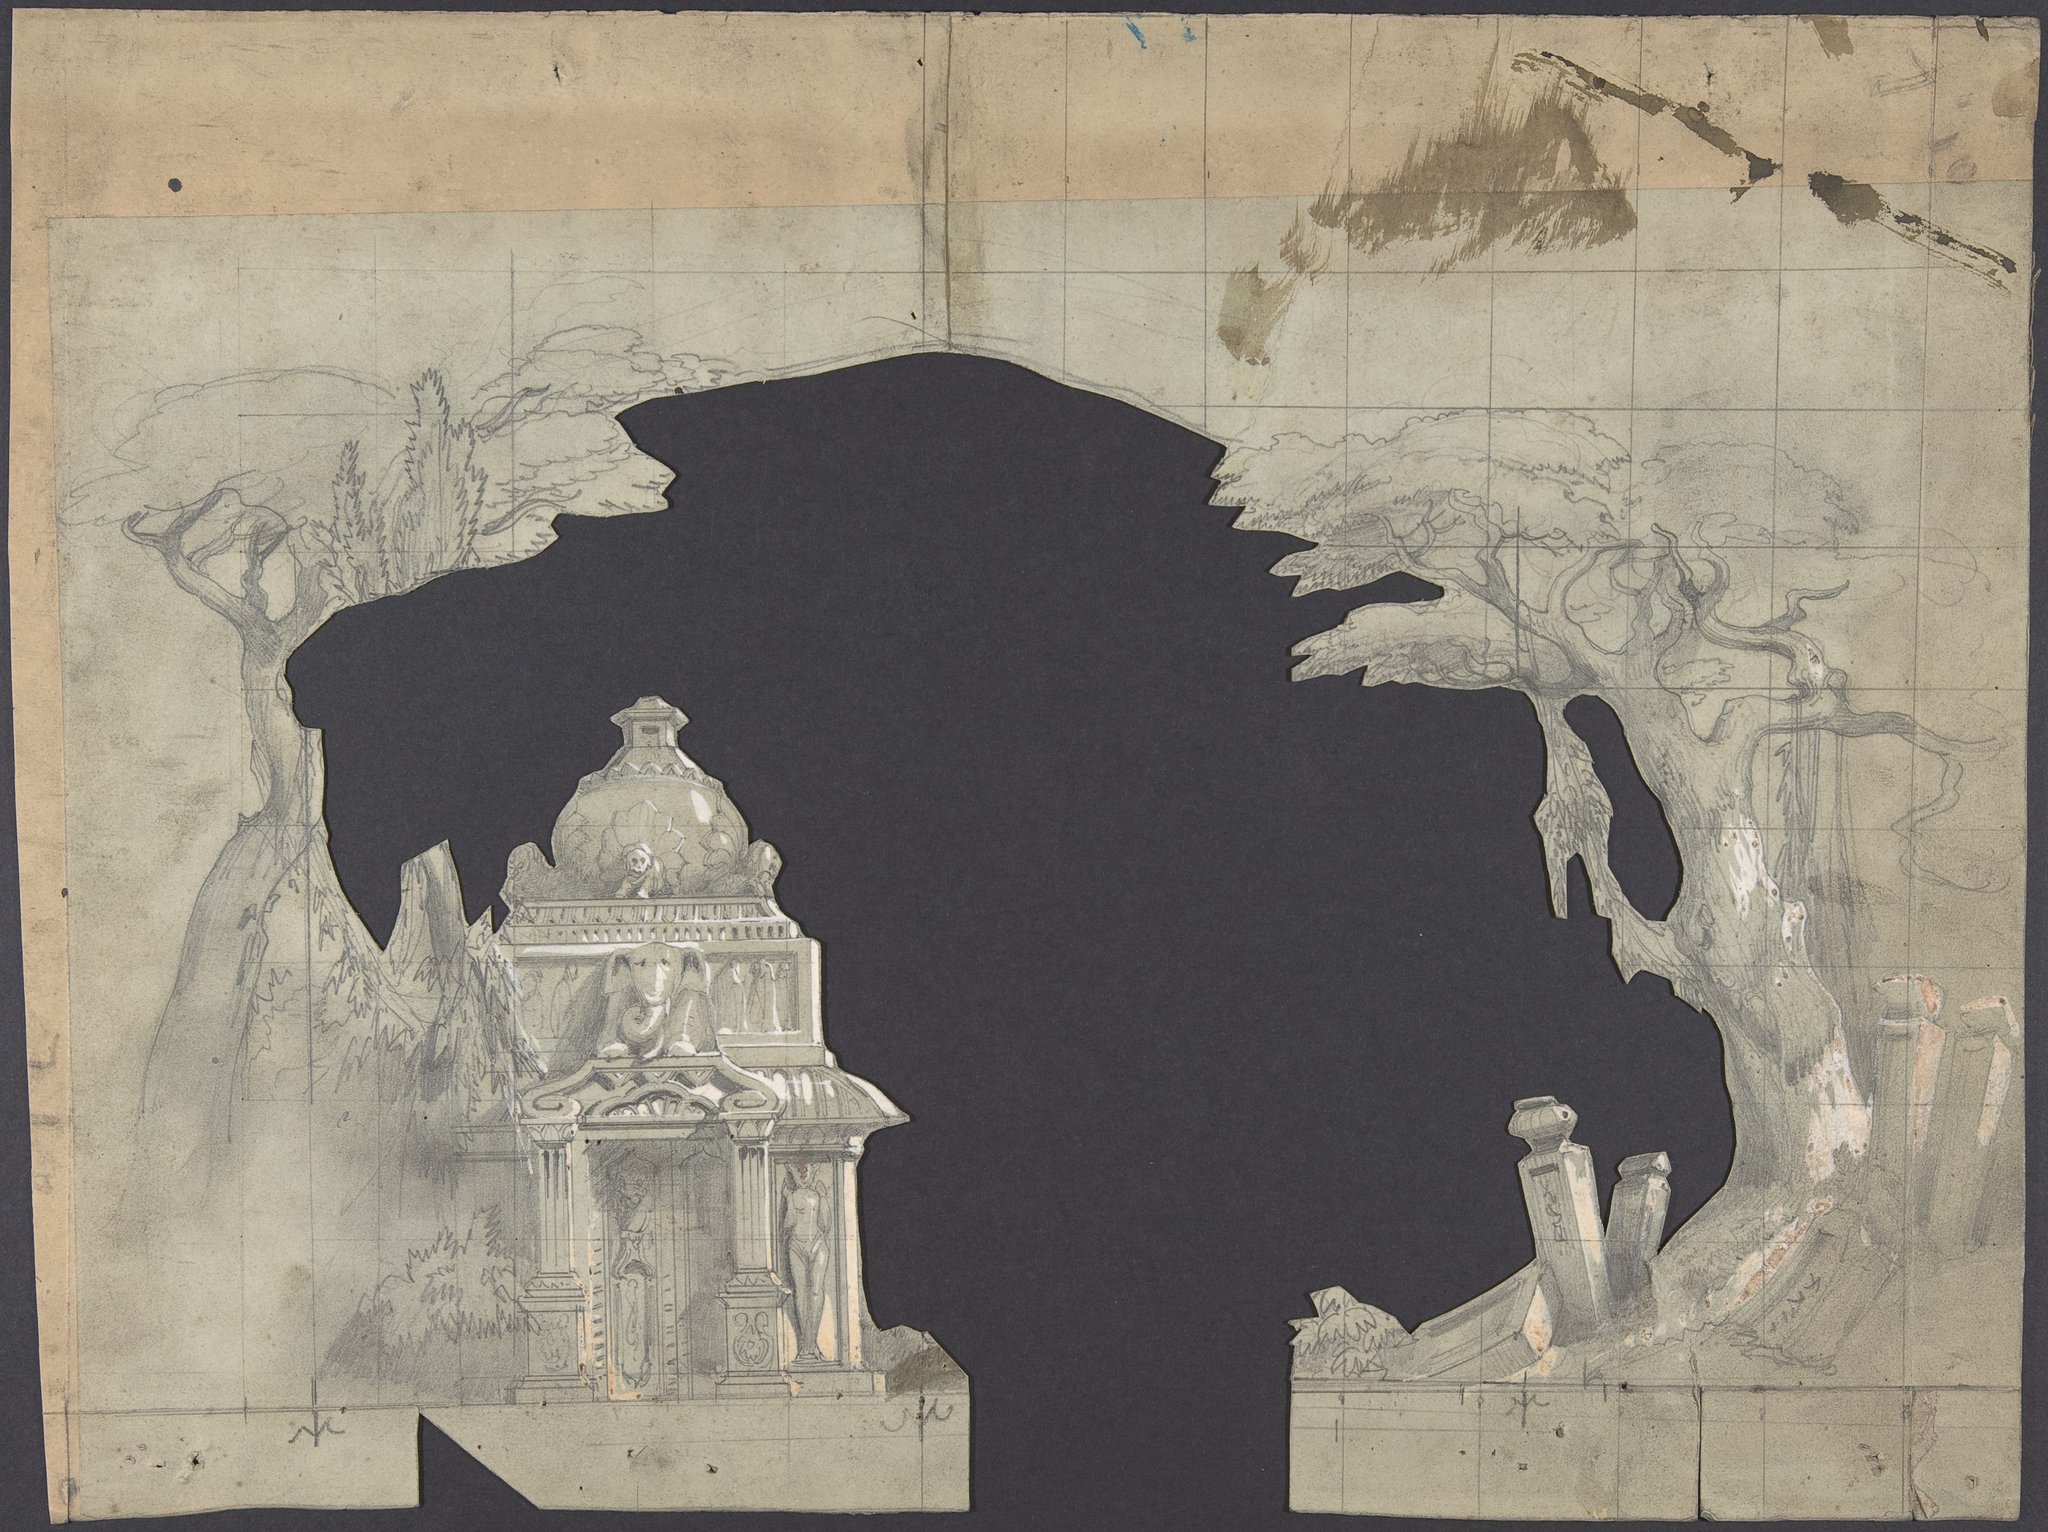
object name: drawing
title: Design for a Stage Set at the Opéra, Paris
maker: eugène cicéri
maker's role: artist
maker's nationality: french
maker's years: 1813-1890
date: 1825-1890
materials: graphite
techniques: heightening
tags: trees,stage design